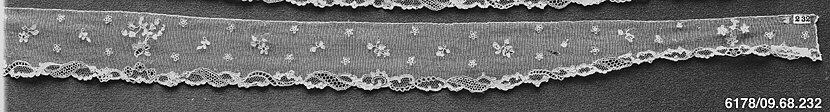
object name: textile fragment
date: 1801-1900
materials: metal thread, silk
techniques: brocade, weave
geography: india